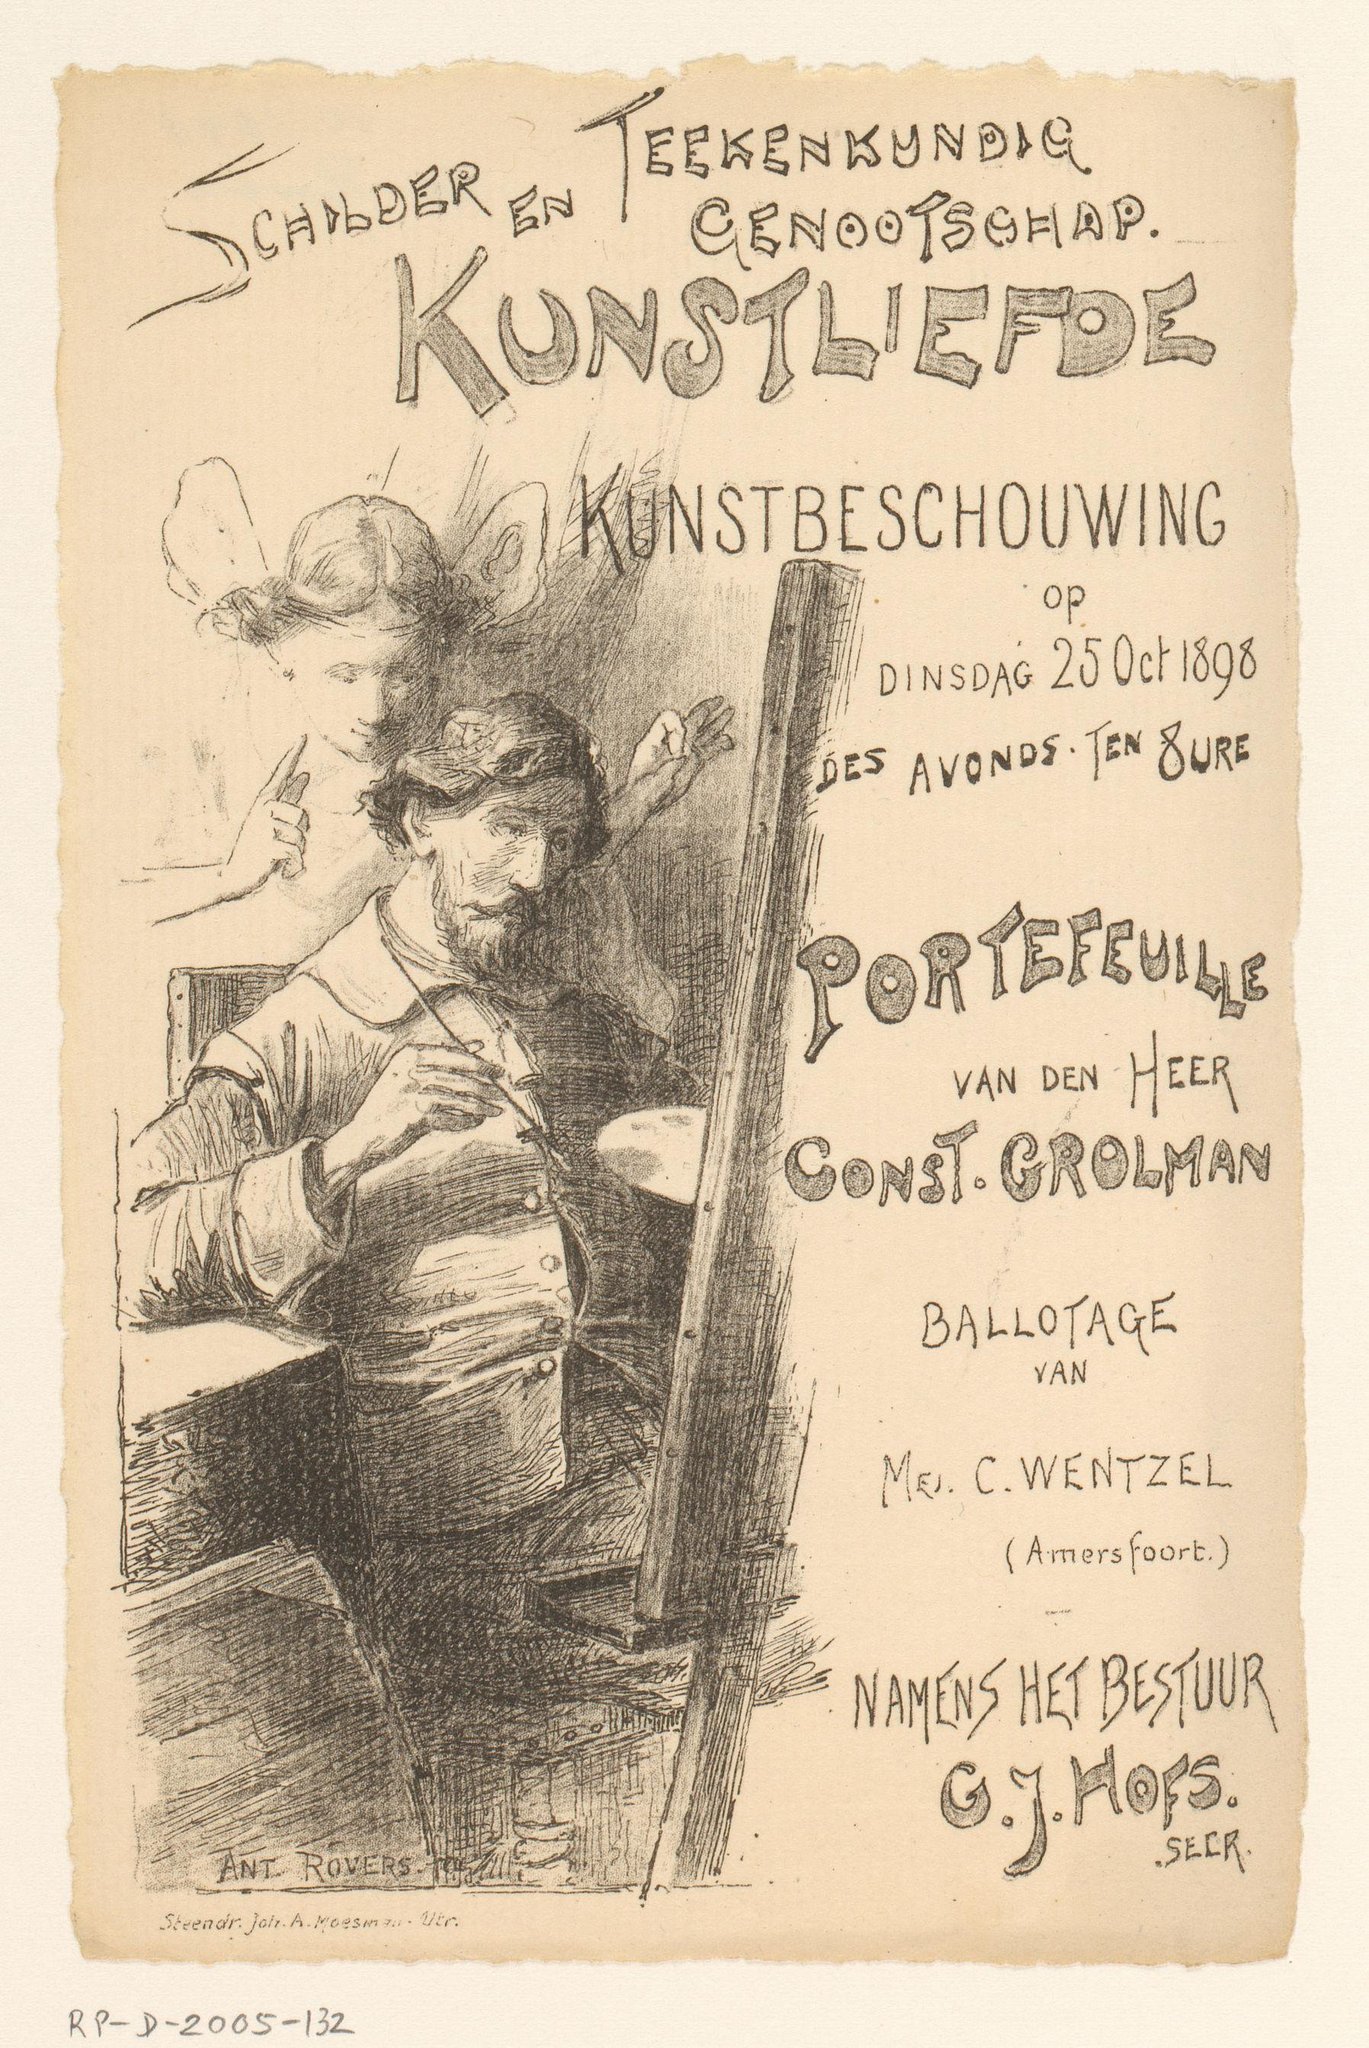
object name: invitation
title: Uitnodiging van Schilder- en Teekenkundig Genootschap "Kunstliefde" voor een kunstbeschouwing, 25 oktober 1898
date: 1810-1898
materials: paper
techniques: lithograph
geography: netherlands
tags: criticizing and discussing art, art criticism, circle, club of artists, collecting and exhibiting products of the fine arts, inspiration of the painter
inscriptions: collector's mark: Lugt 2228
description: De Inspiratie of de muze fluistert in het oor van de schilder. Uitnodiging van Schilder- en Teekenkundig Genootschap "Kunstliefde" voor een kunstbeschouwing op 25 oktober 1898 van de portefeuille van dhr. Const. Grolman.